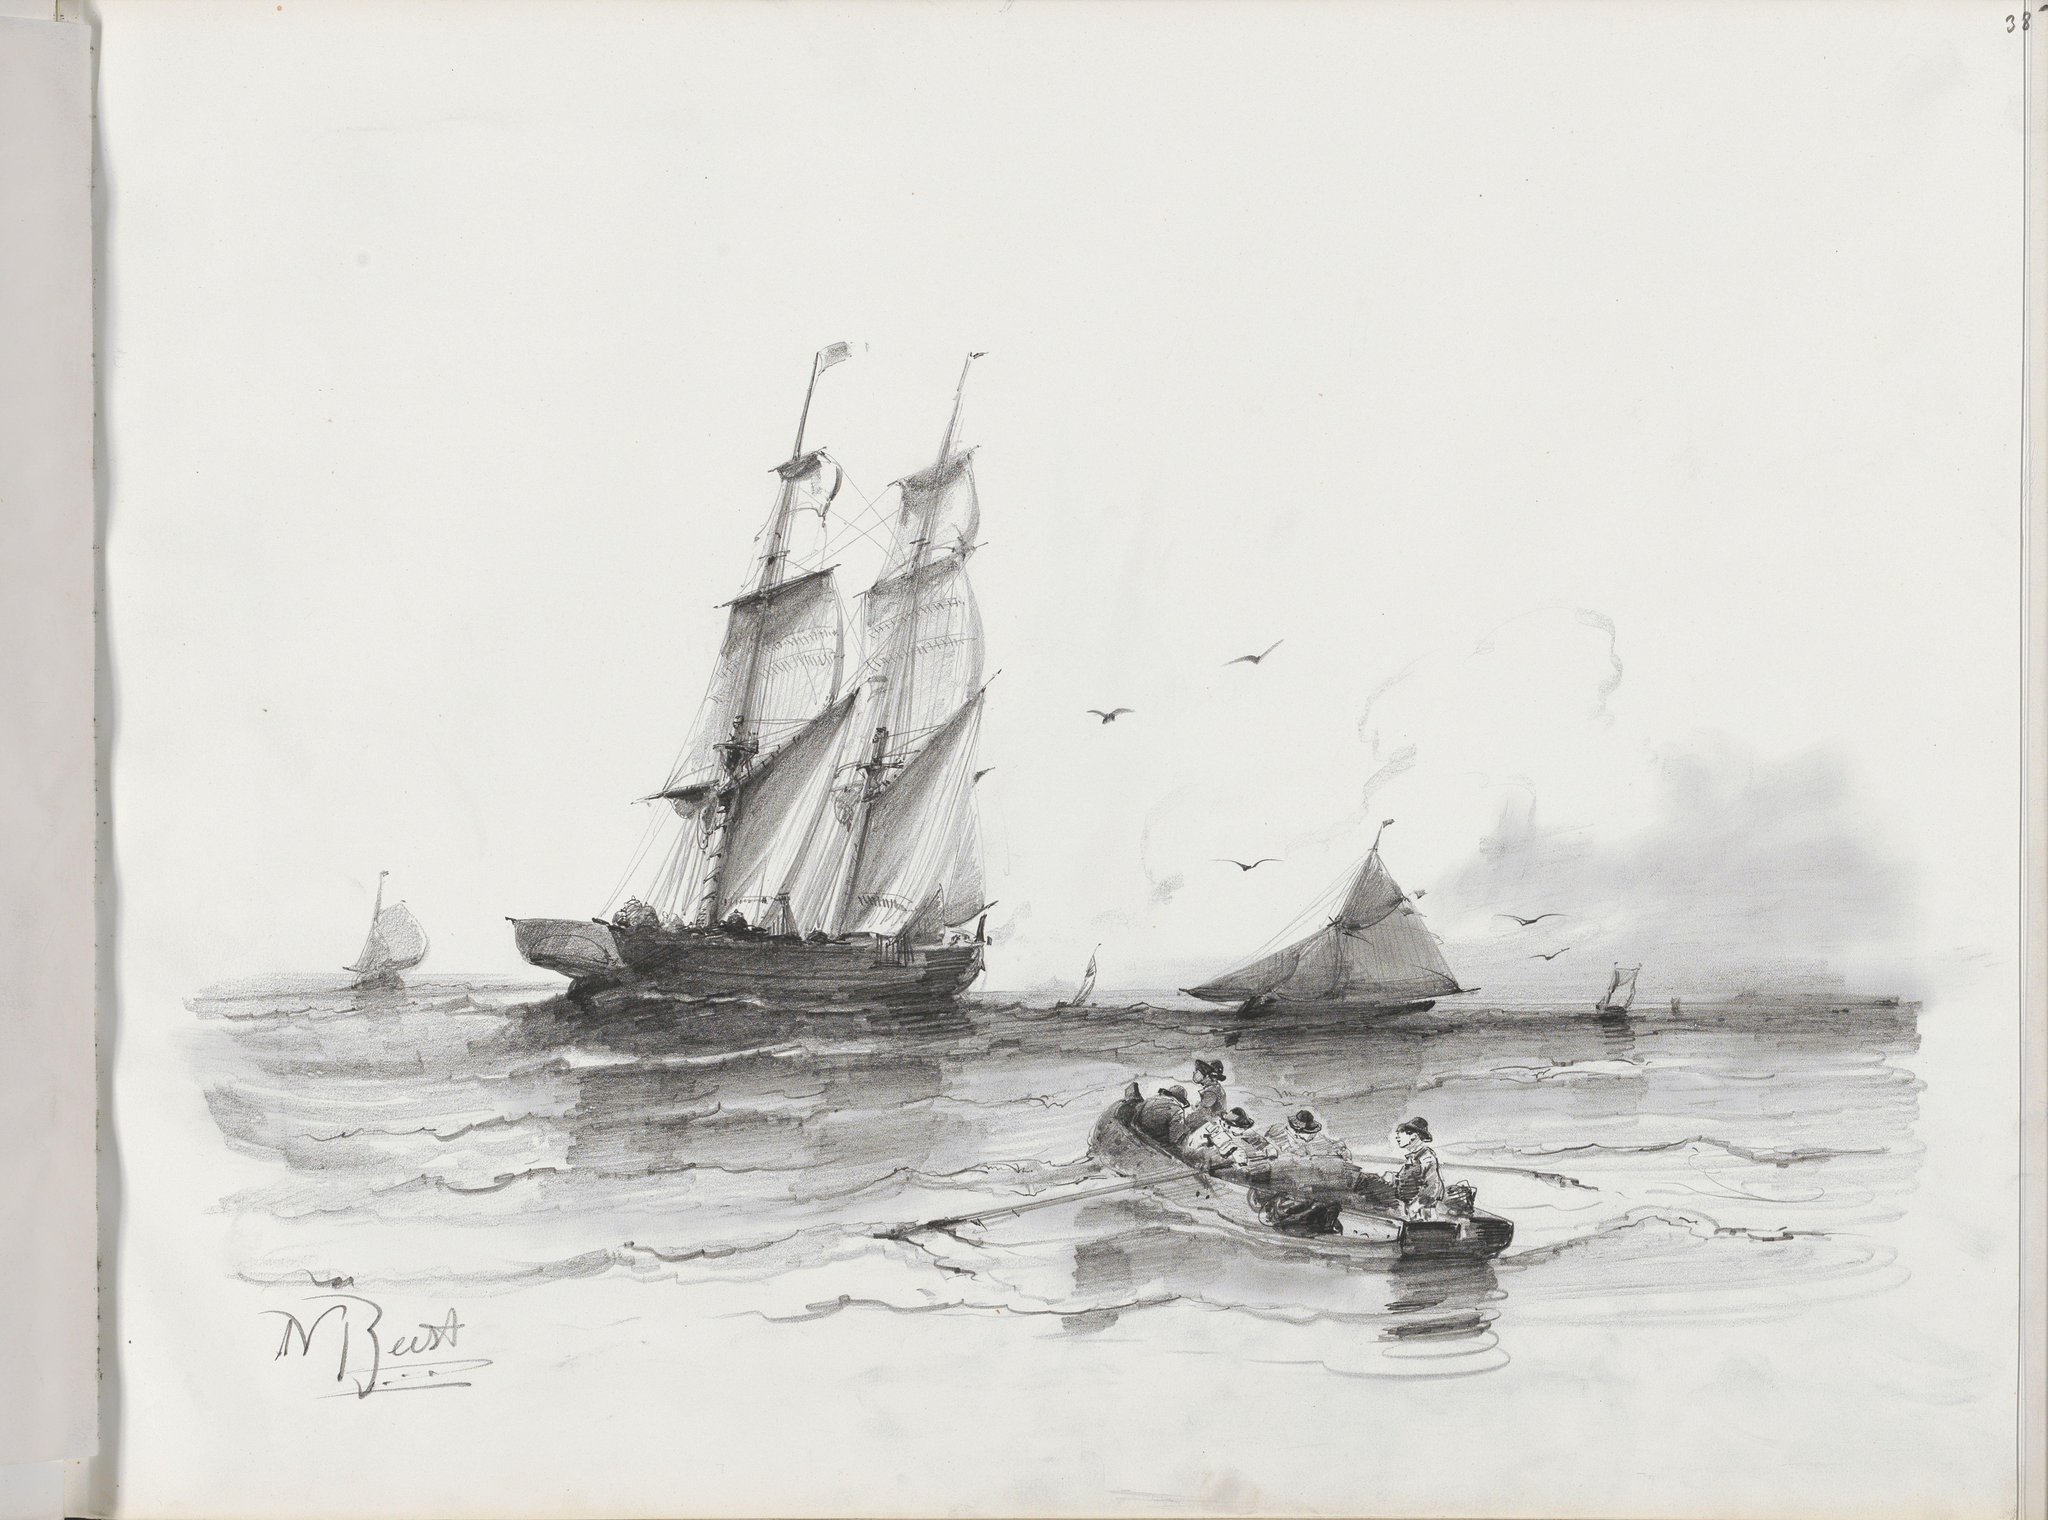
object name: sketchbook leaf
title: Zeilboten, een tweemaster en roeiboot op het water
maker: albertus van beest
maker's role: draughtsman, print maker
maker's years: 1820-1860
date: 1830-1860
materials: paper, pencil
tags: sailing-ship, sailing-boat, landscapes with waters, waterscapes, seascapes (in the temperate zone), rowing-boat, canoe, etc.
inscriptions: signature: ‘AV Beest’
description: Blad 38 recto uit een schetsboek met 46 bladen.